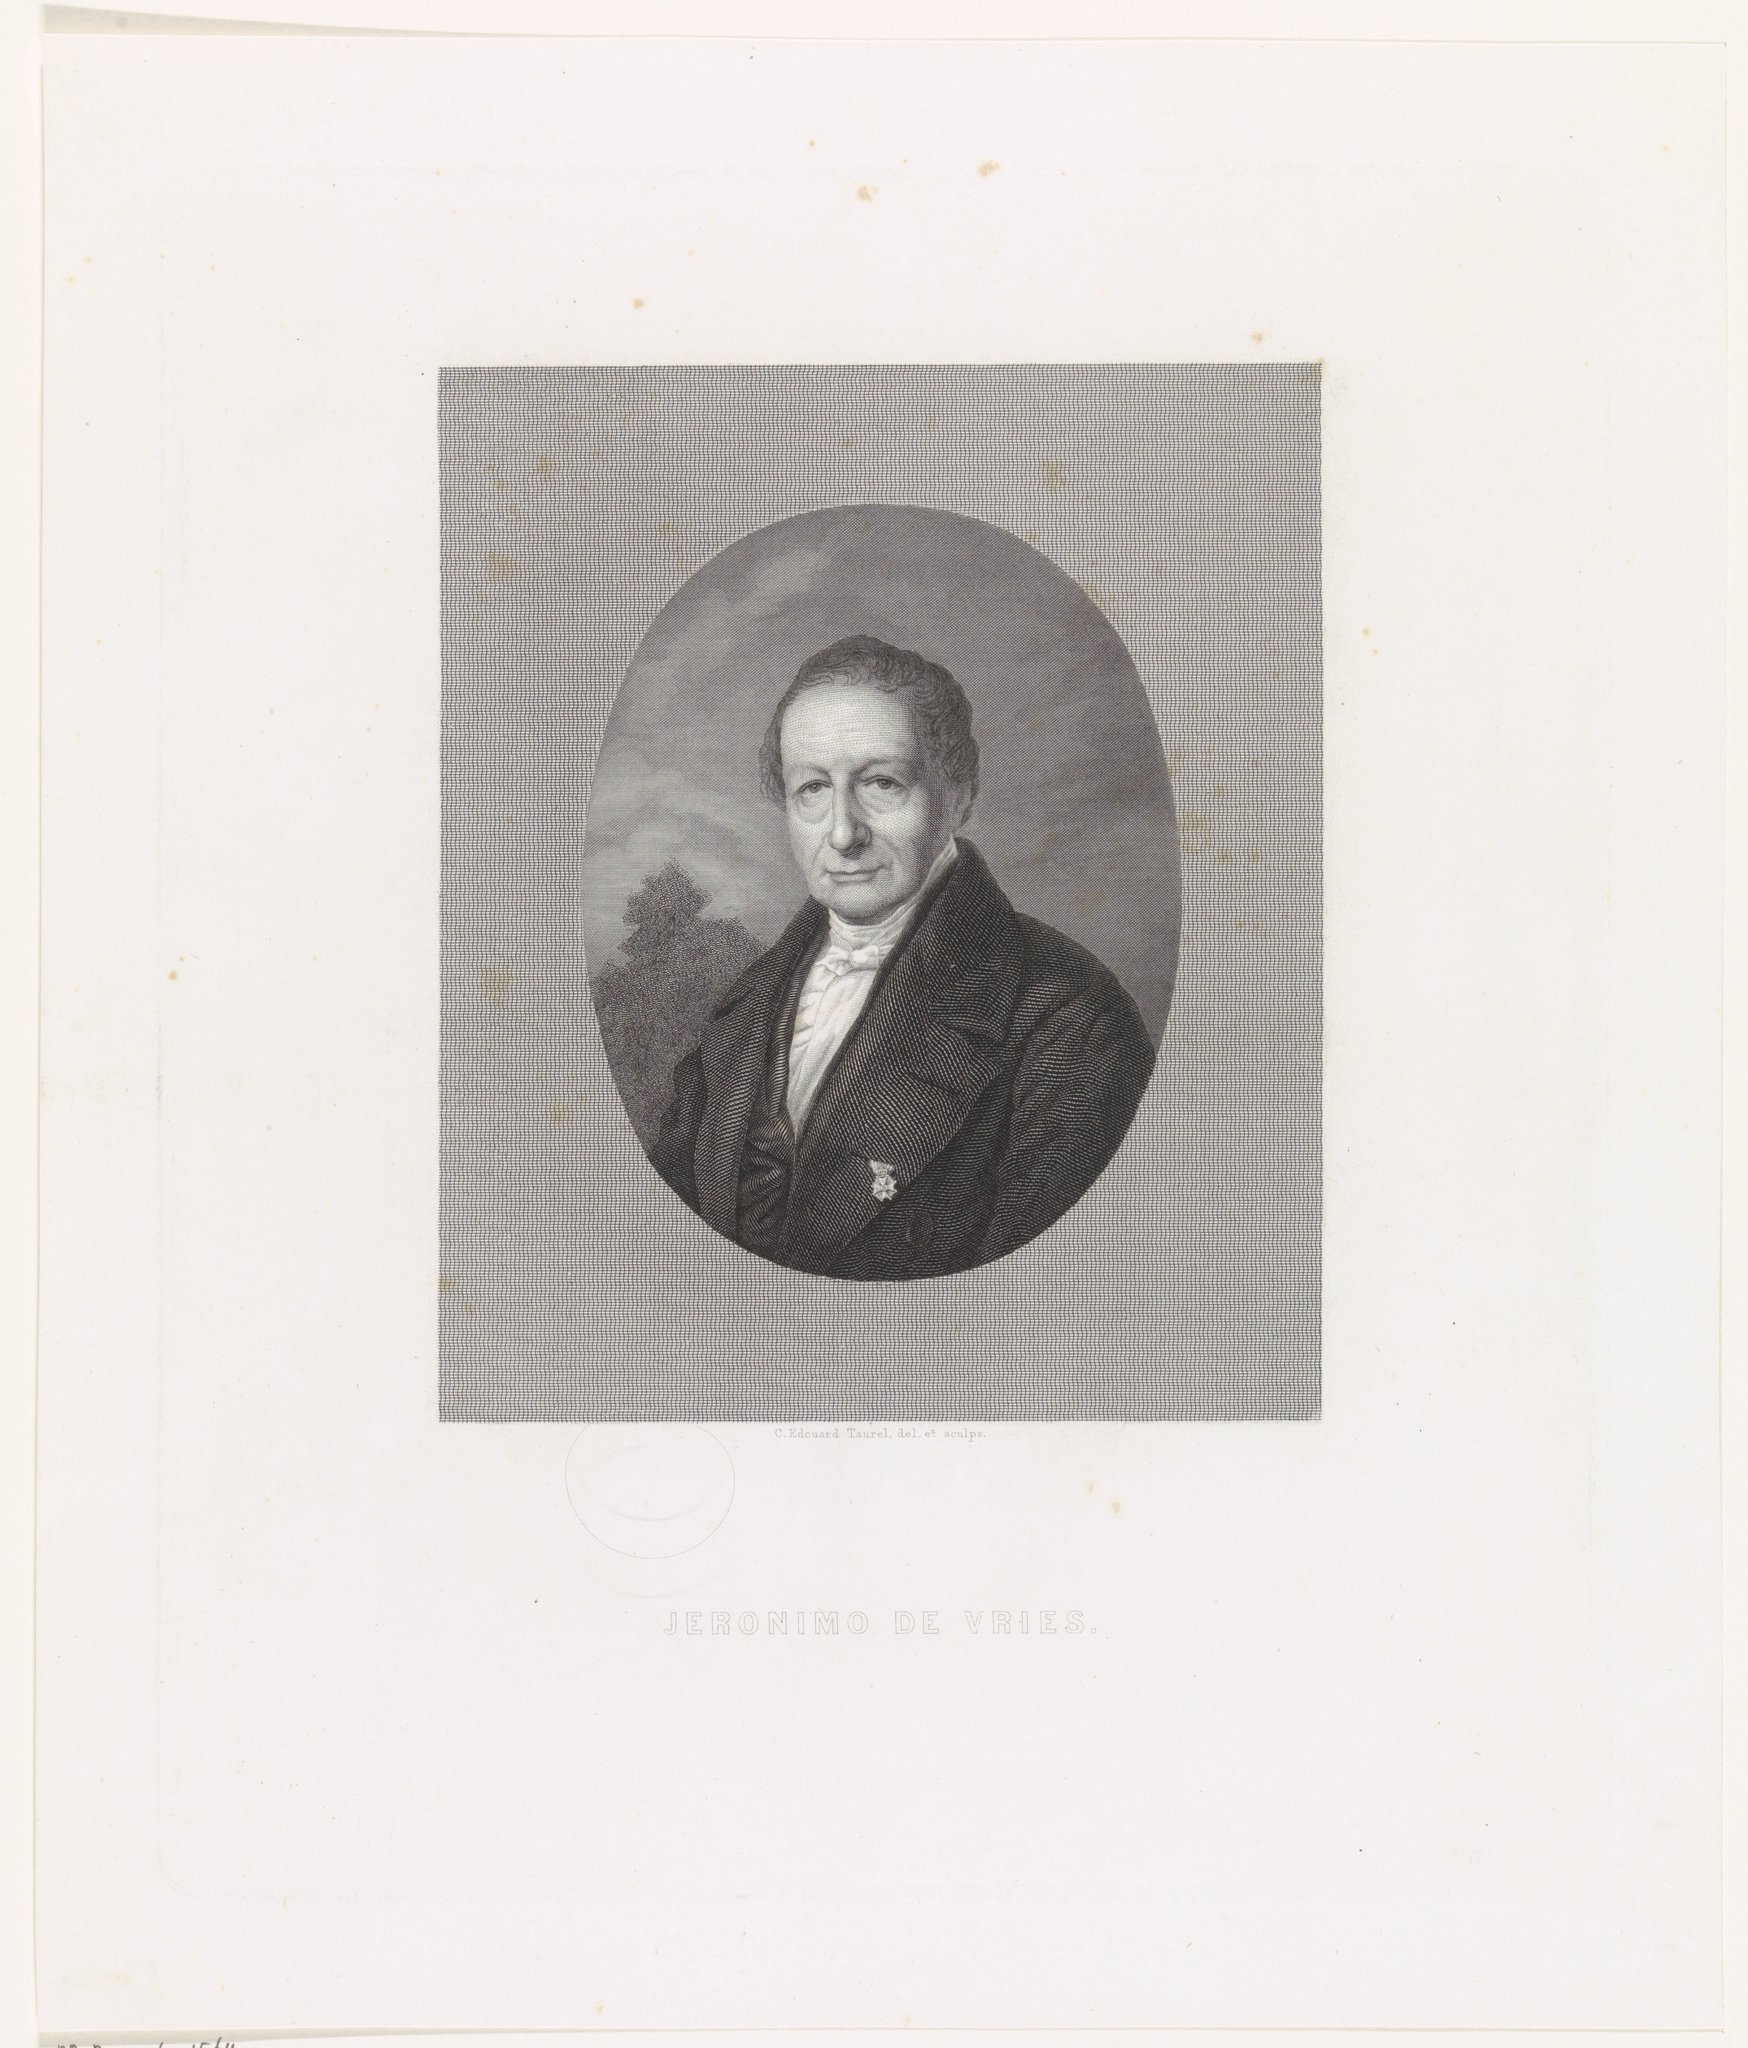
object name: print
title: Portret van Jeronimo de Vries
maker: edouard taurel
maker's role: draughtsman, print maker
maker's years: 1824-1892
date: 1834-1853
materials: paper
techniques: engraving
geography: amsterdam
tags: amsterdam, jeronimo de vries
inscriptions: collector's mark: Lugt 2228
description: Portret van de Amsterdamse stadssecretaris Jeronimo de Vries.